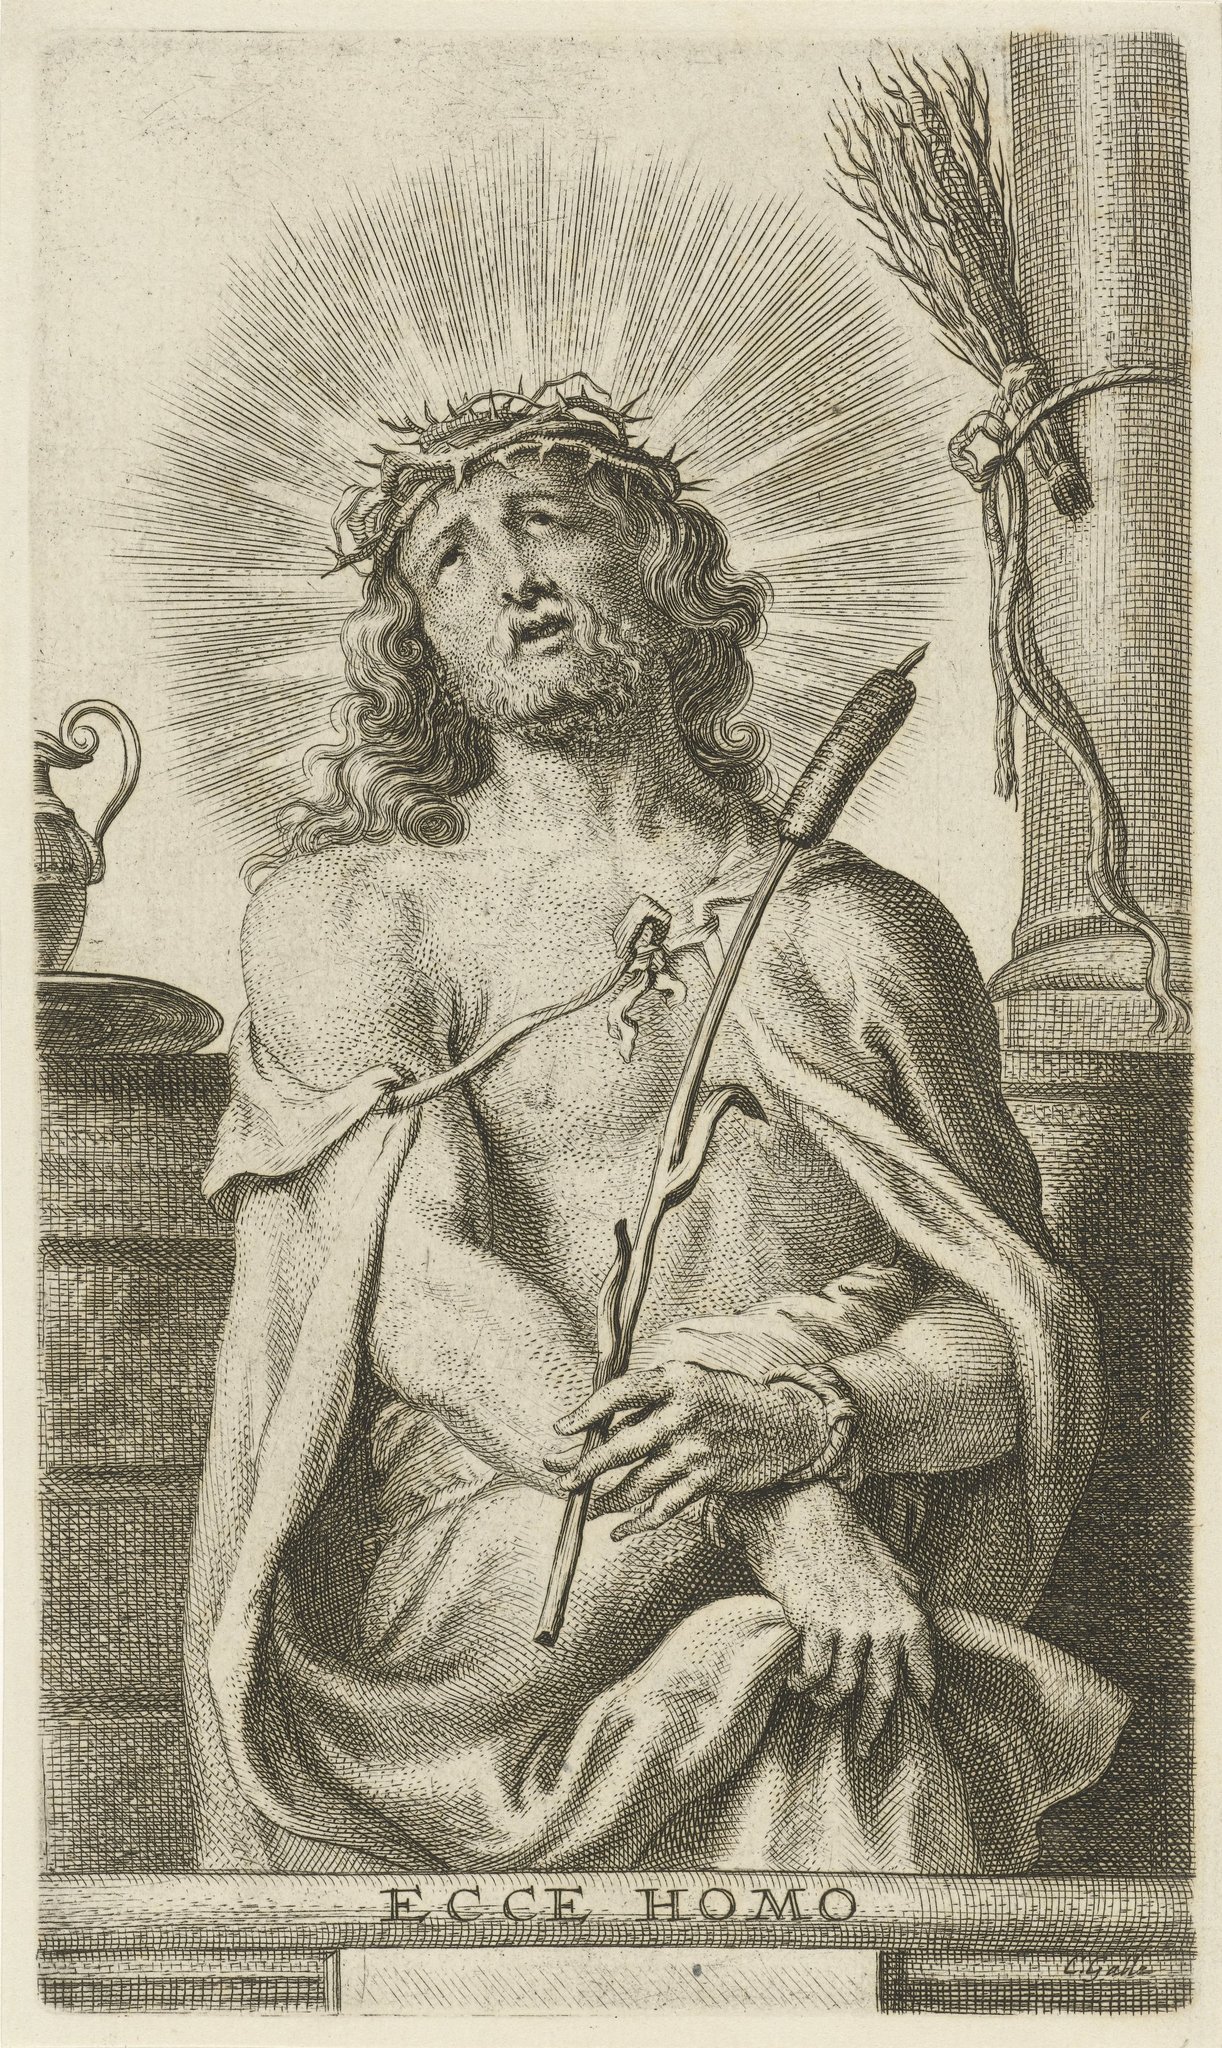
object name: print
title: Christus aan het volk getoond (Ecce homo)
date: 1638-1678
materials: paper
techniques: engraving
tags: pilate showing christ to the people, 'ostentatio christi', 'ecce homo' (john 19:4-6)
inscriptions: collector's mark: Lugt 2228